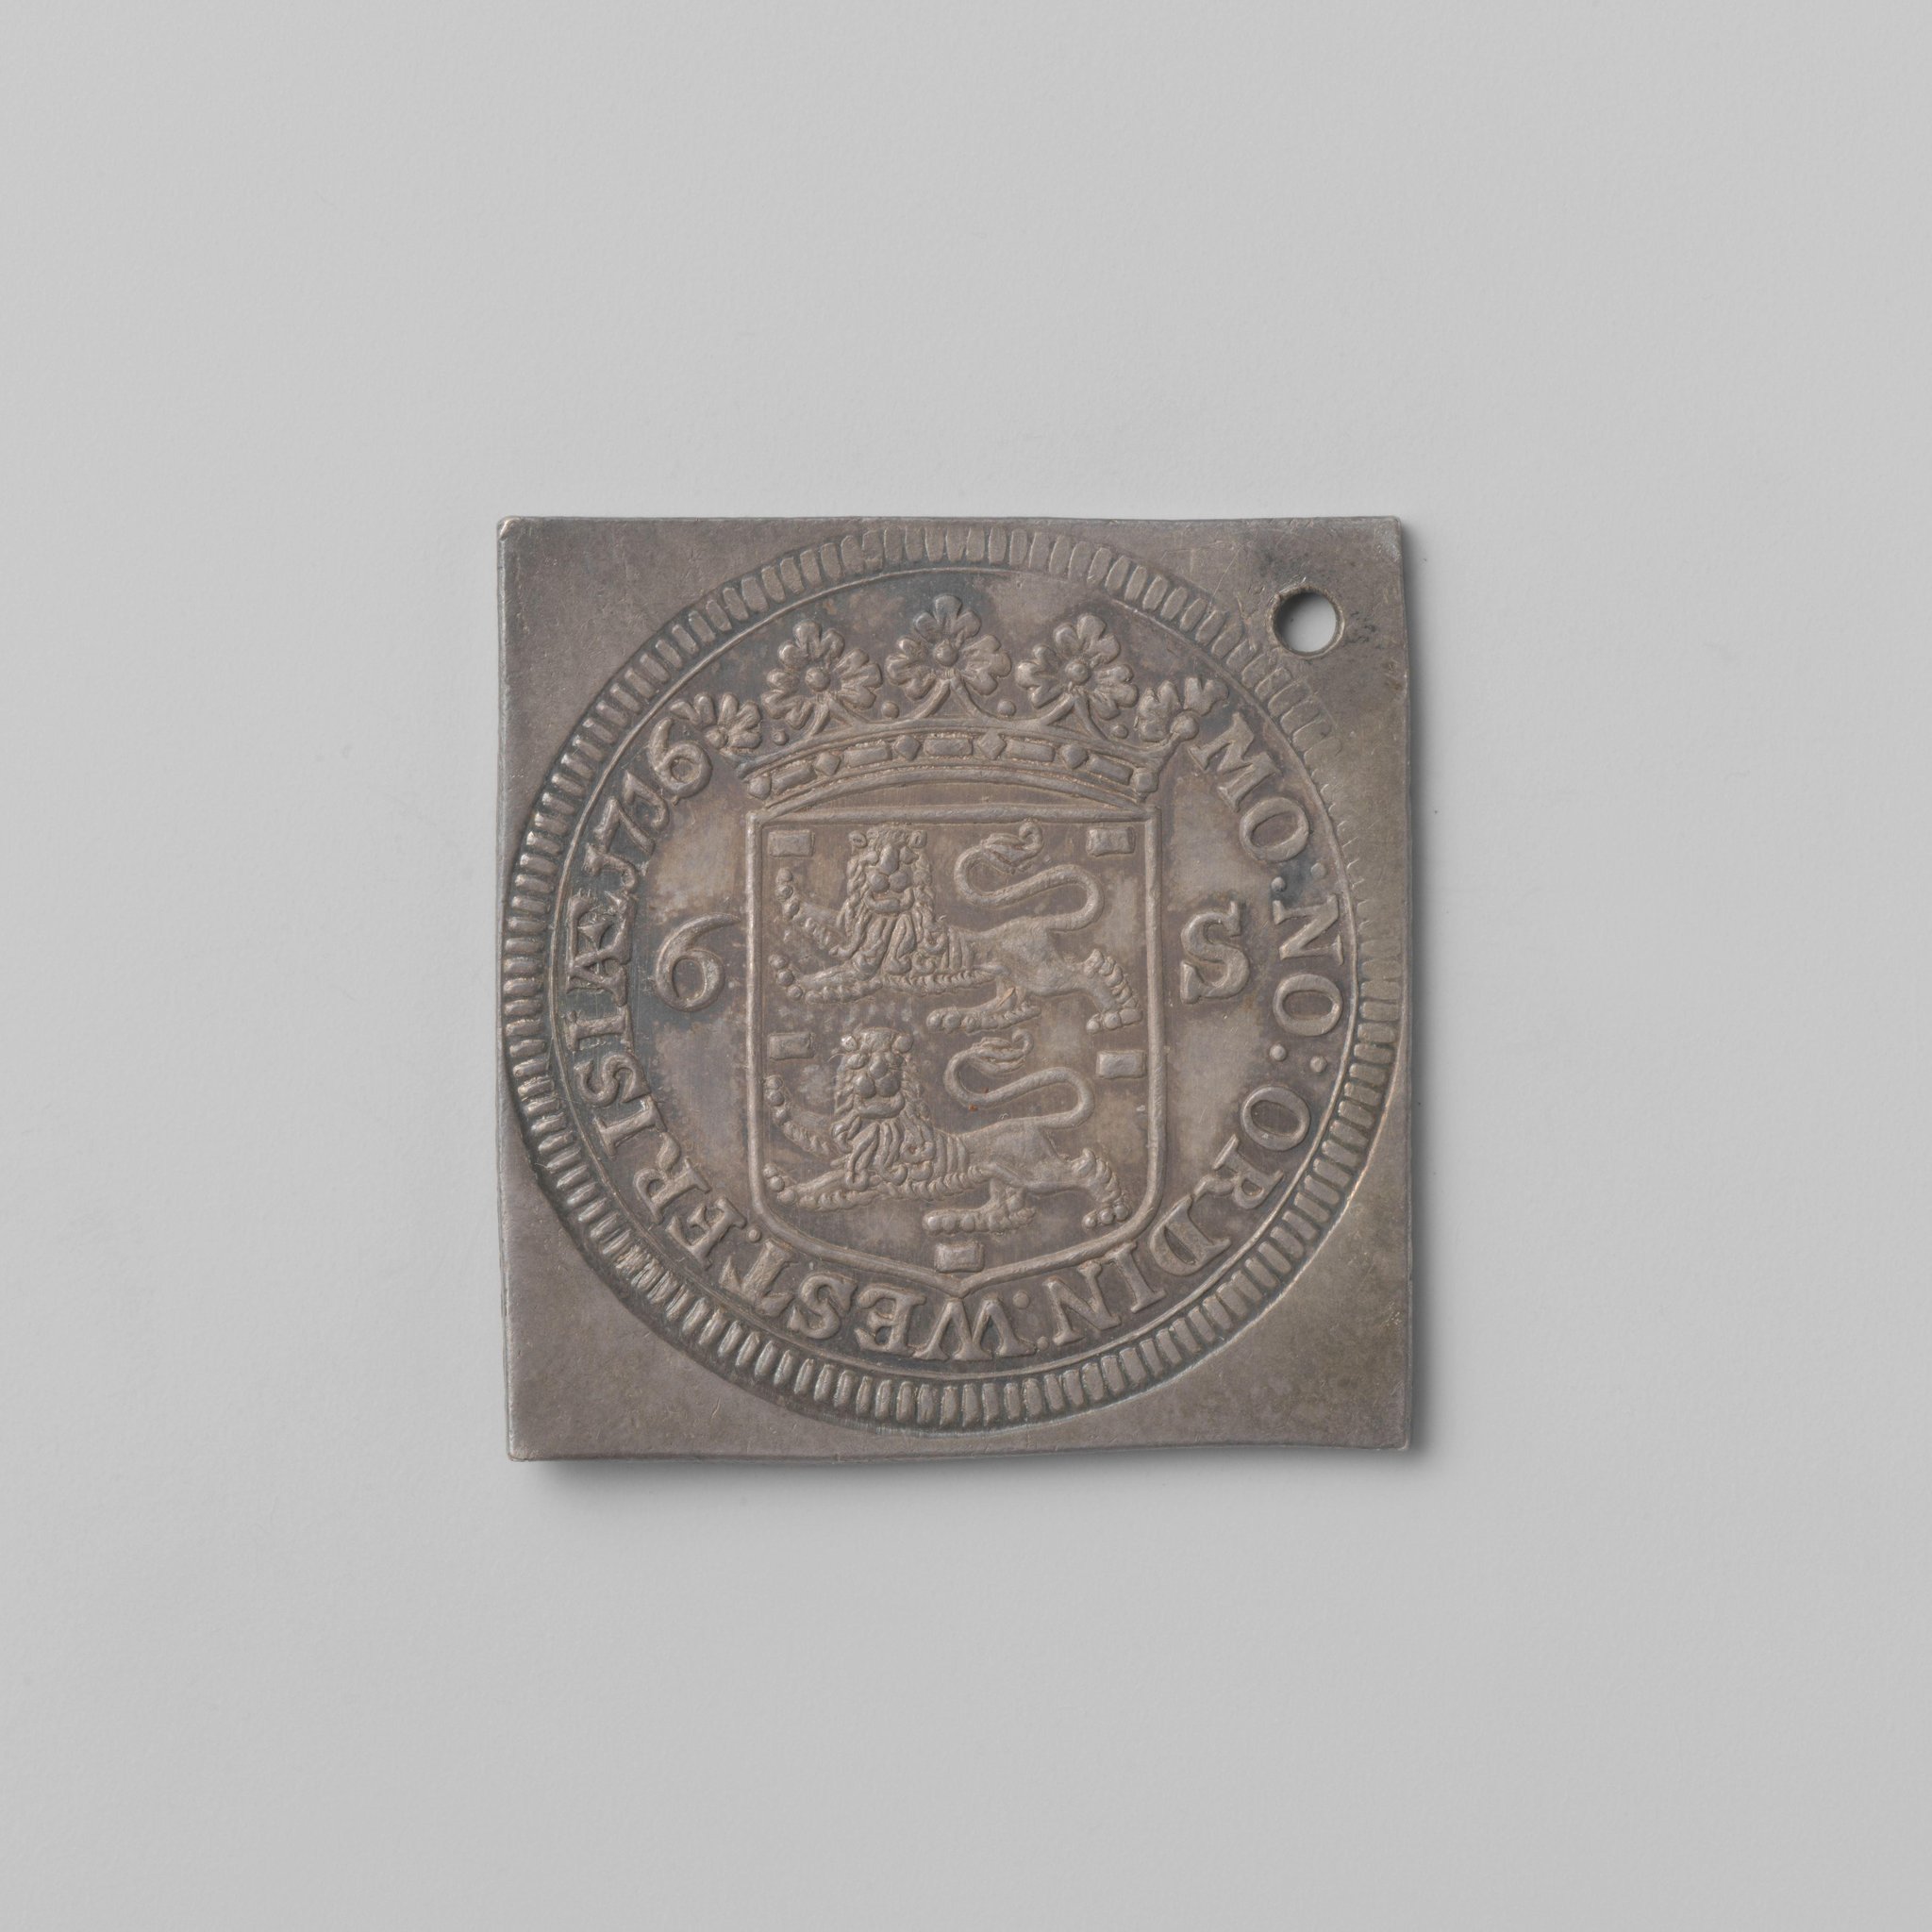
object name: coin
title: West-Friesland, scheepjesschelling, 1716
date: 1716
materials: silver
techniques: striking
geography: west frisia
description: Zilveren vierkante munt. Voorzijde: tussen waarde-aanduiding 6 S gekroond wapenschild van West-Friesland. jaartal aan eind van omschrift. Keerzijde: schip met zeilen naar rechts. Vierkante afslag